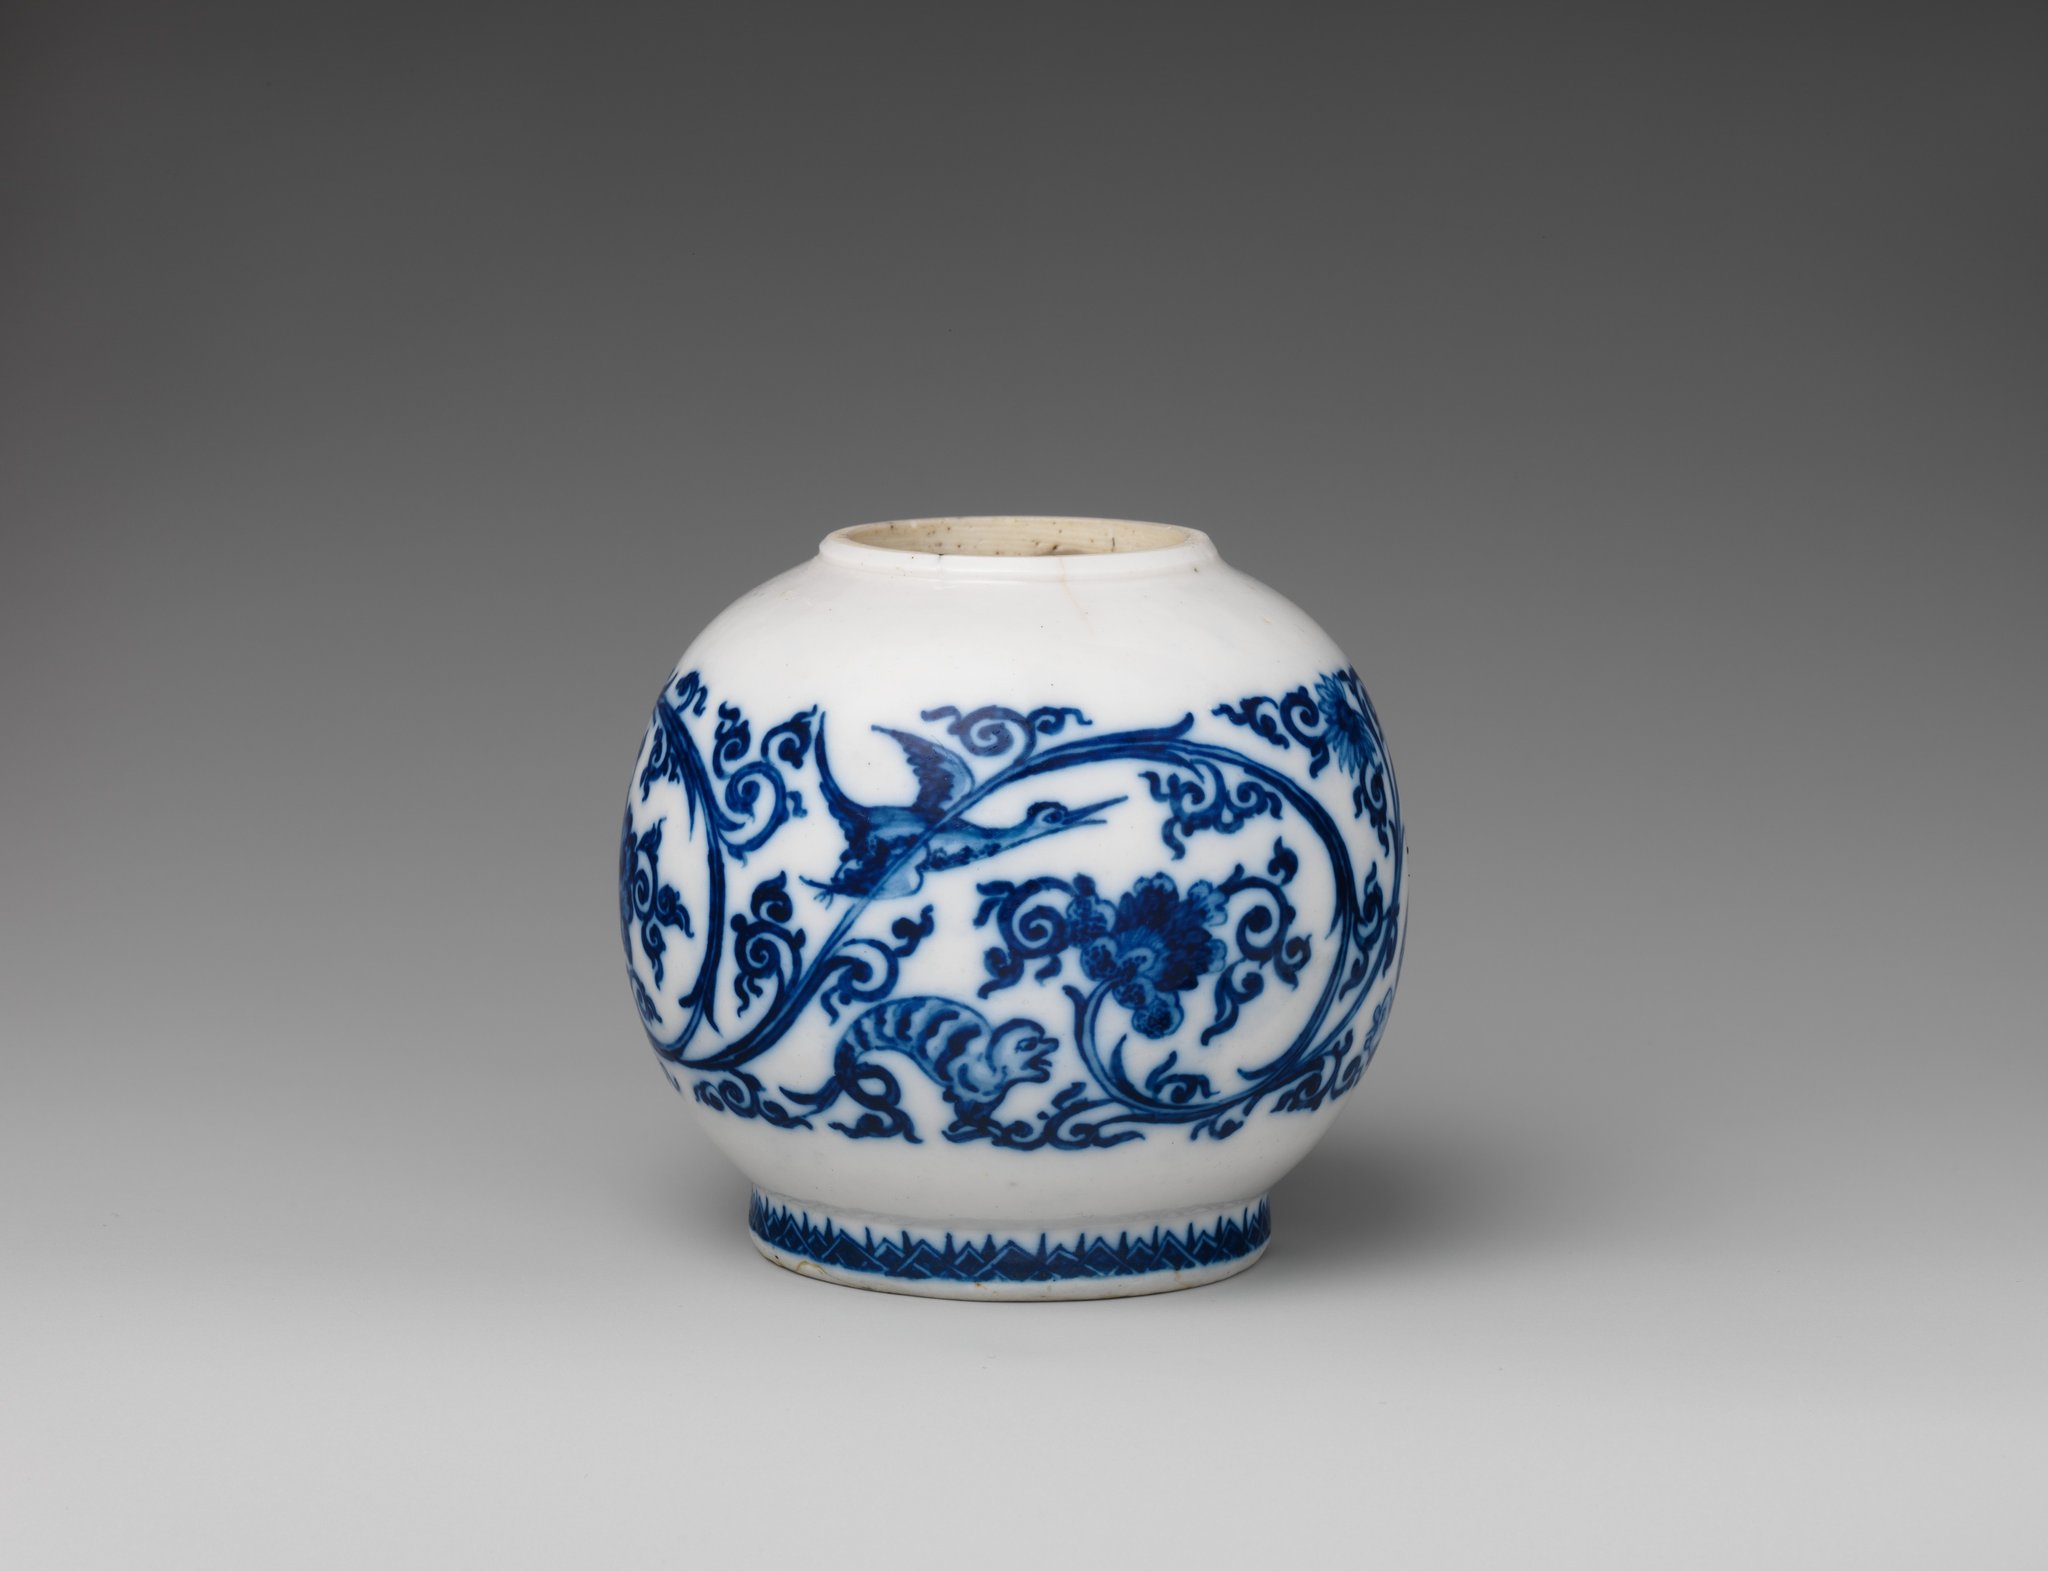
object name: vase with cover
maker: saint-cloud factory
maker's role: factory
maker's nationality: french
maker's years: 1693-1766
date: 1690-1700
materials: soft paste porcelain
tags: birds